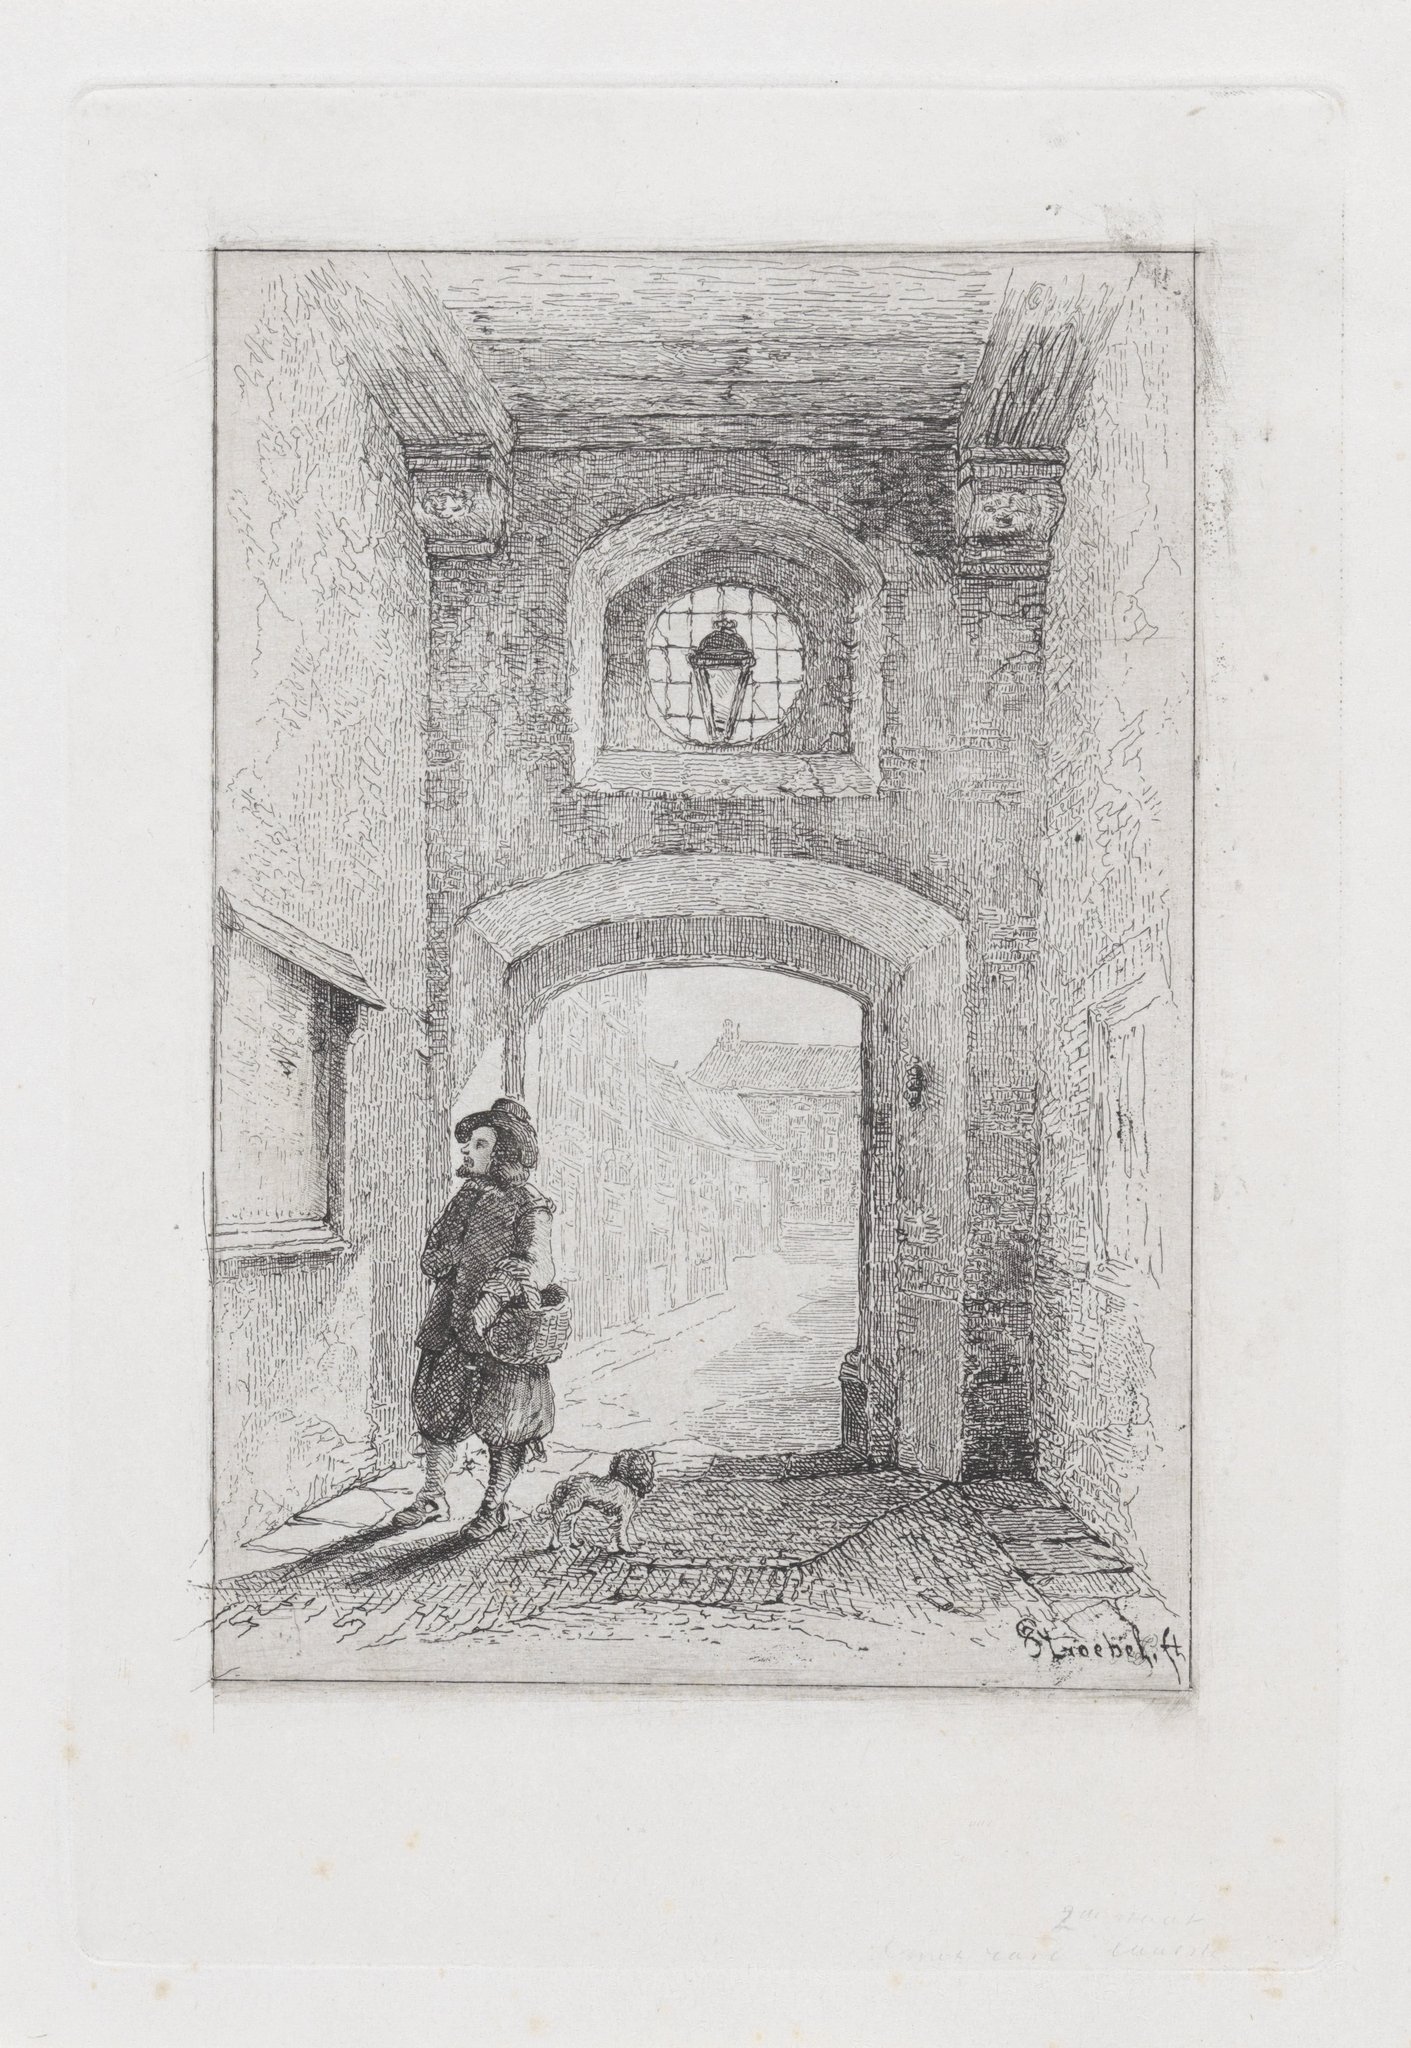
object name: print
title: Man met hond bij een poort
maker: johannes stroebel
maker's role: draughtsman, painter, print maker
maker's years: 1821-1905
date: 1831-1882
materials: paper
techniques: engraving, etching, roulette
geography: netherlands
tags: gate, entrance, dog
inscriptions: collector's mark: Lugt 2228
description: Links staat een man met een mand aan zijn arm een aanplakbord te lezen. Naast hem een hondje, Boven de poort een raam en een lantaarn.